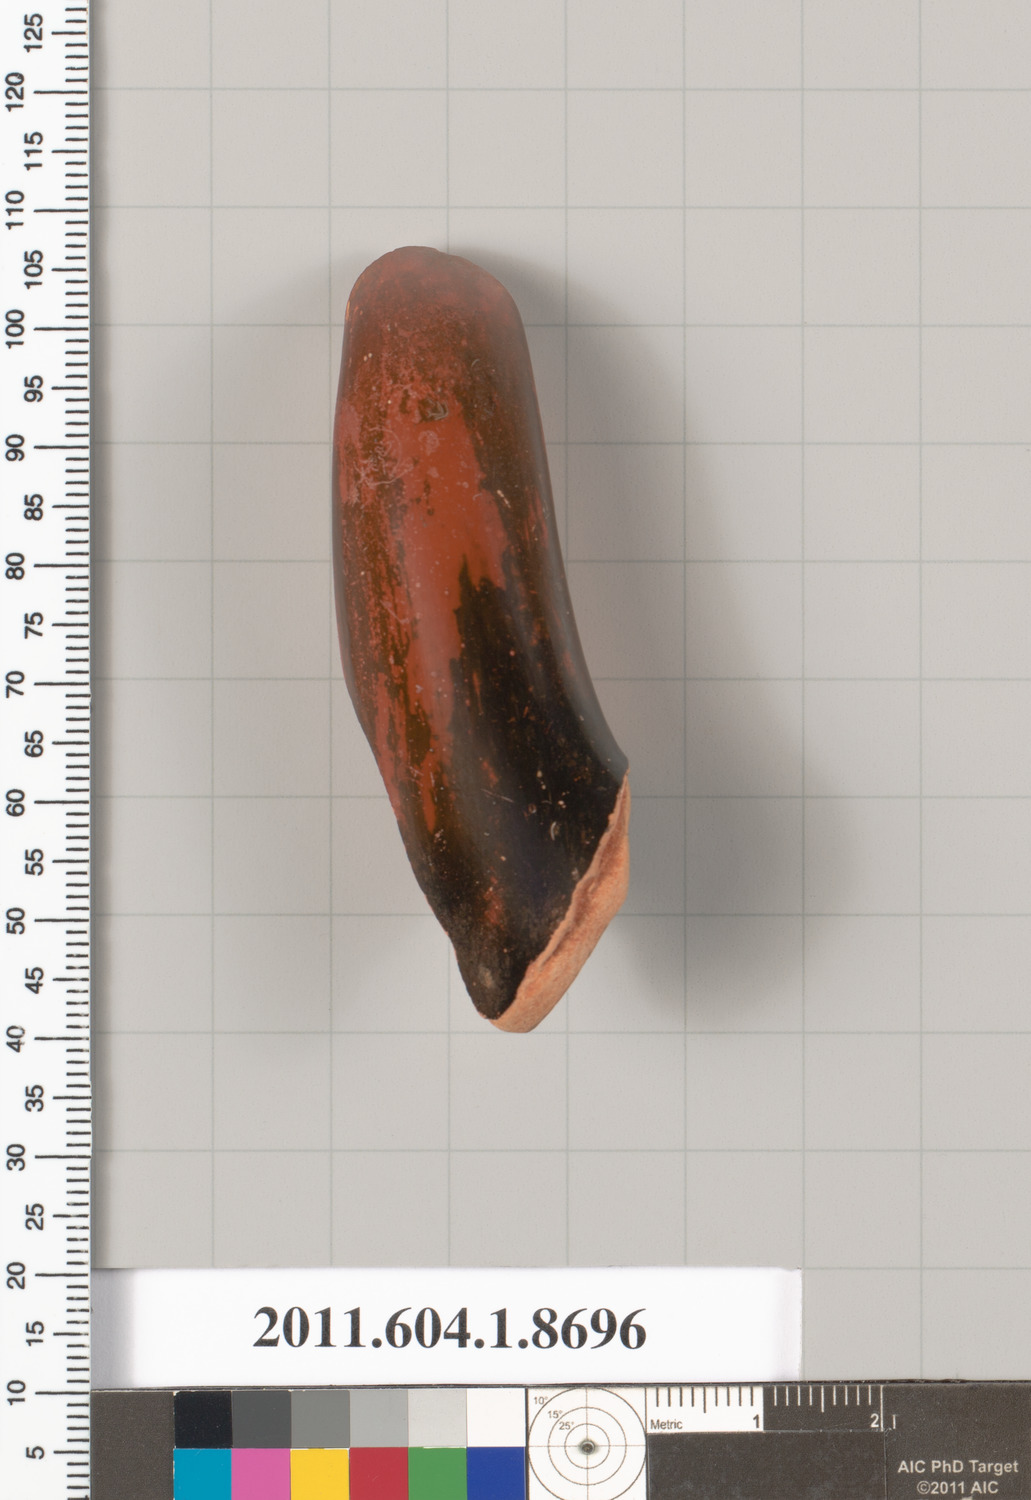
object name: kylix fragment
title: Terracotta fragment of a stemless kylix (drinking cup)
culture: greek, attic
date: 470-450 BCE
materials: terracotta